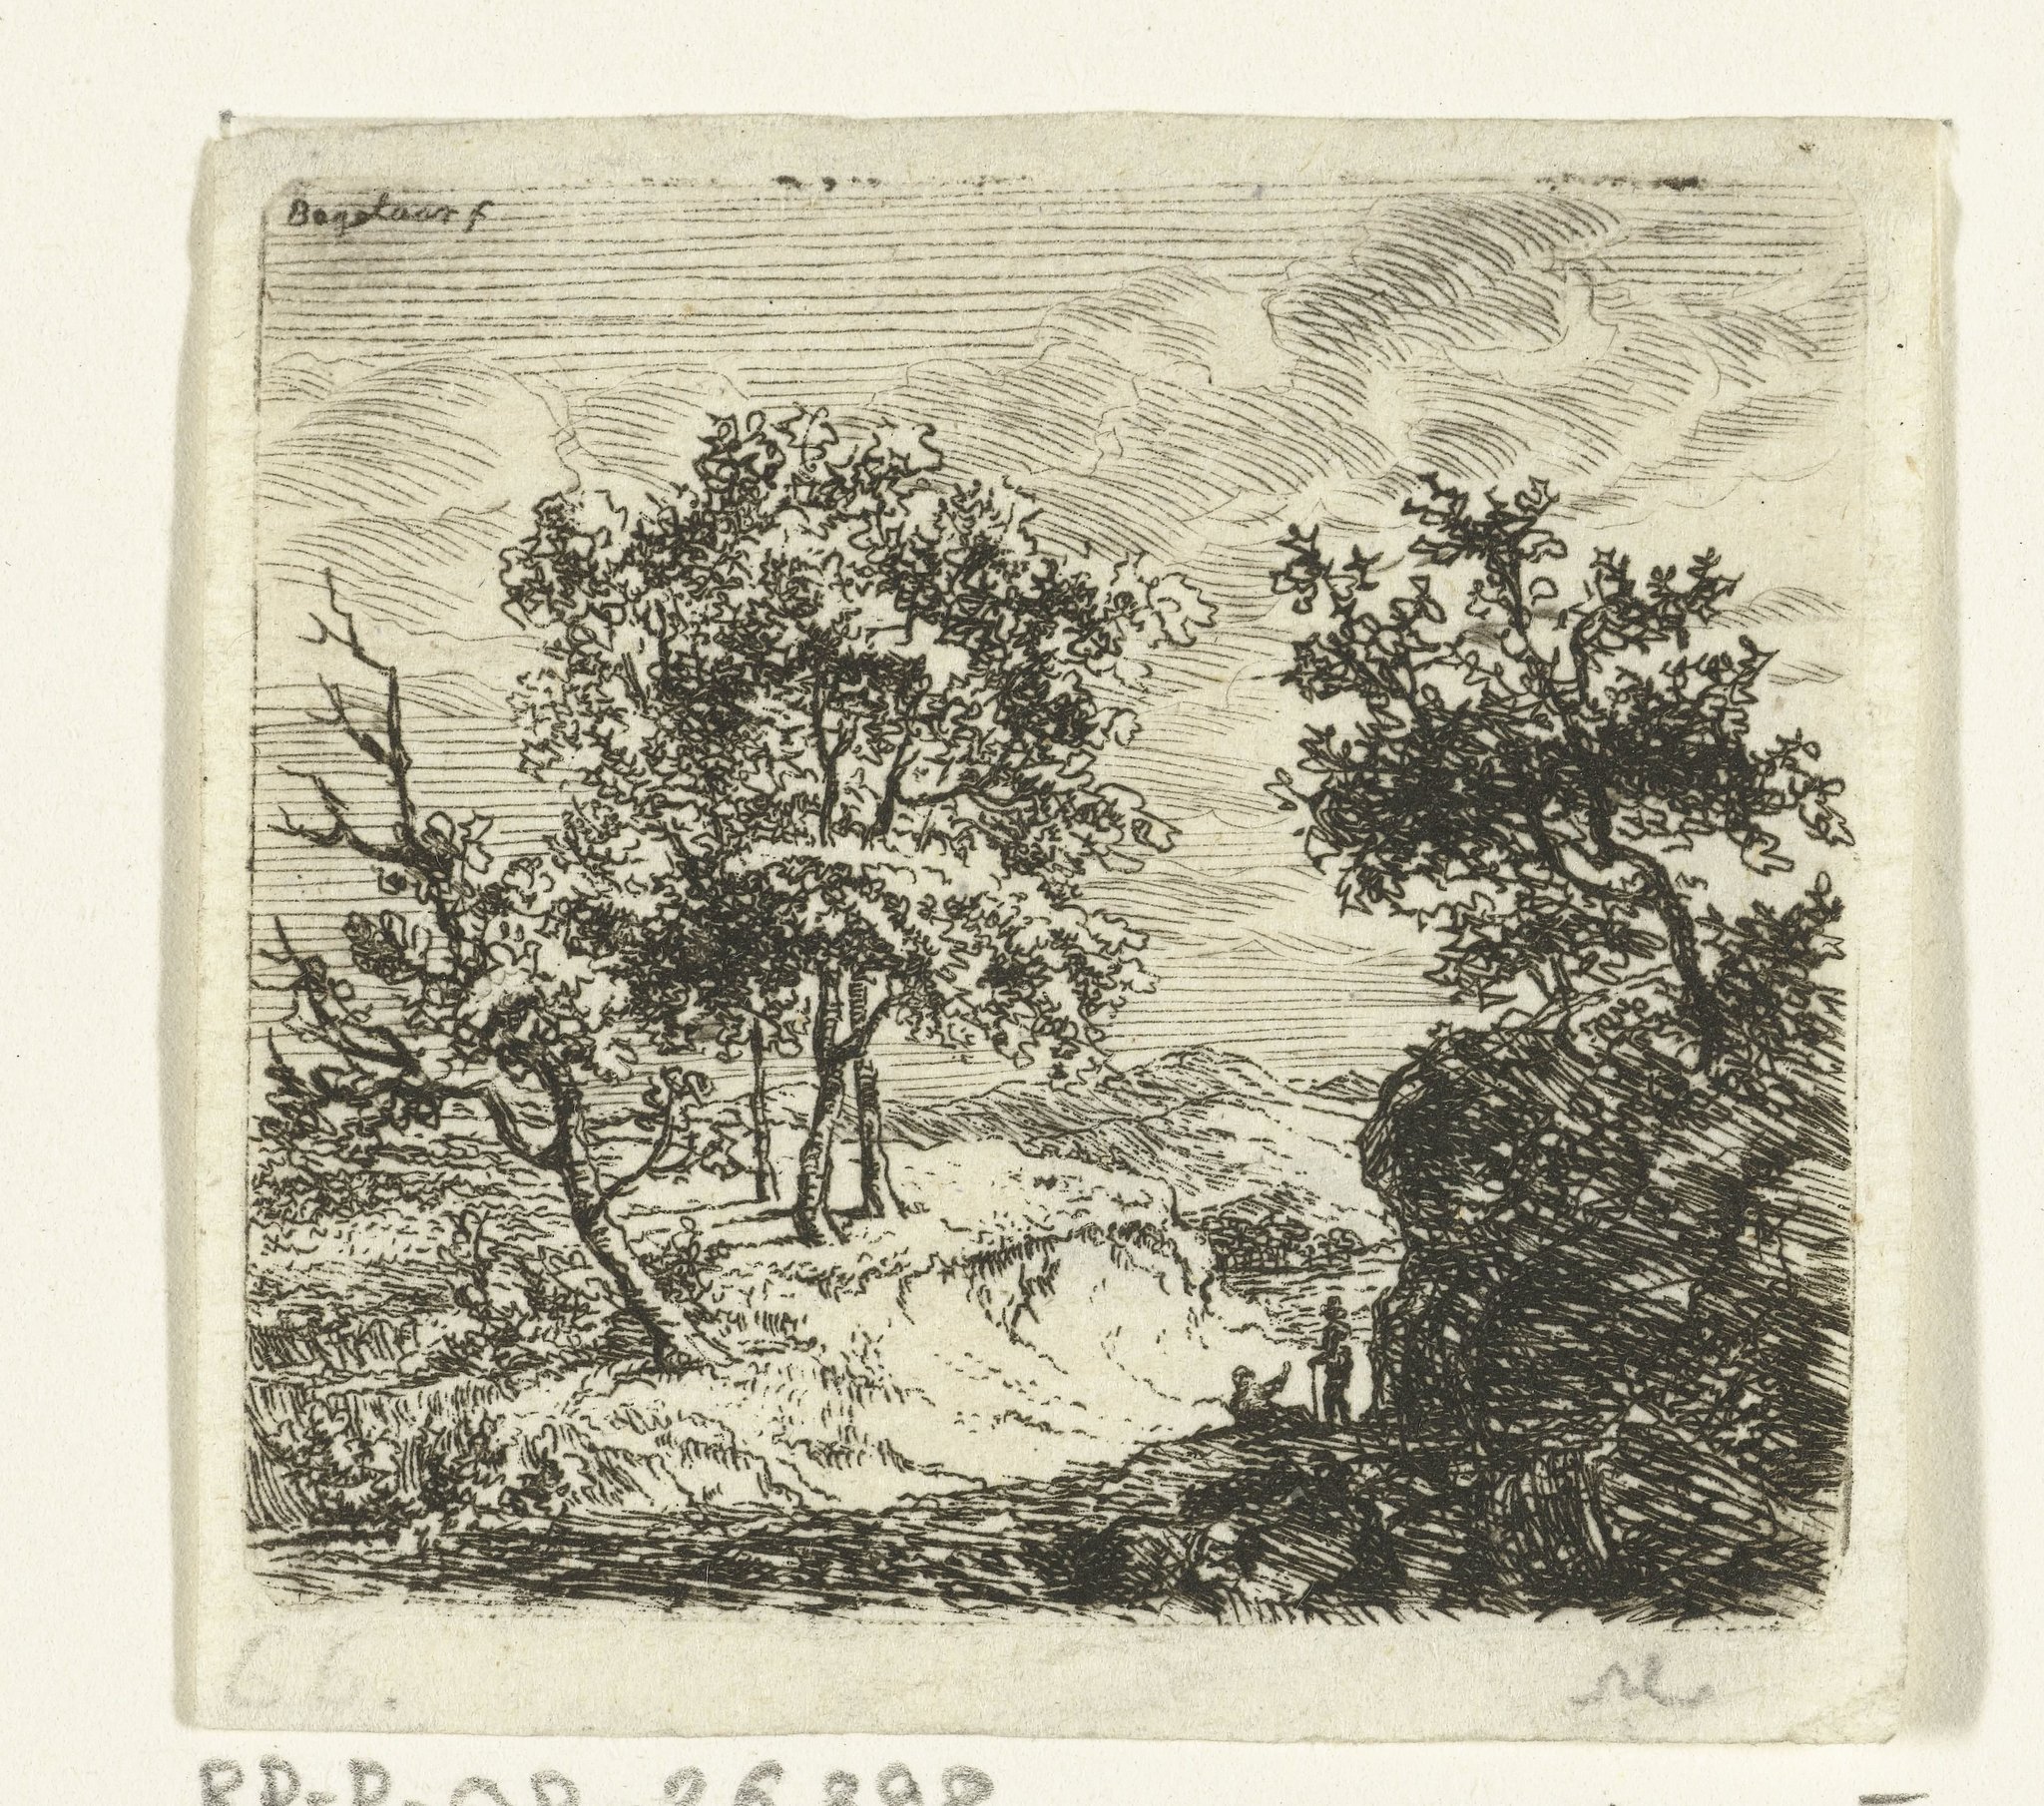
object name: print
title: Heuvellandschap met twee wandelaars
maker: ernst willem jan bagelaar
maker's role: draughtsman, print maker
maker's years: 1775-1837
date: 1798-1837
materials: paper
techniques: drypoint, etching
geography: netherlands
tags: landscapes in the temperate zone